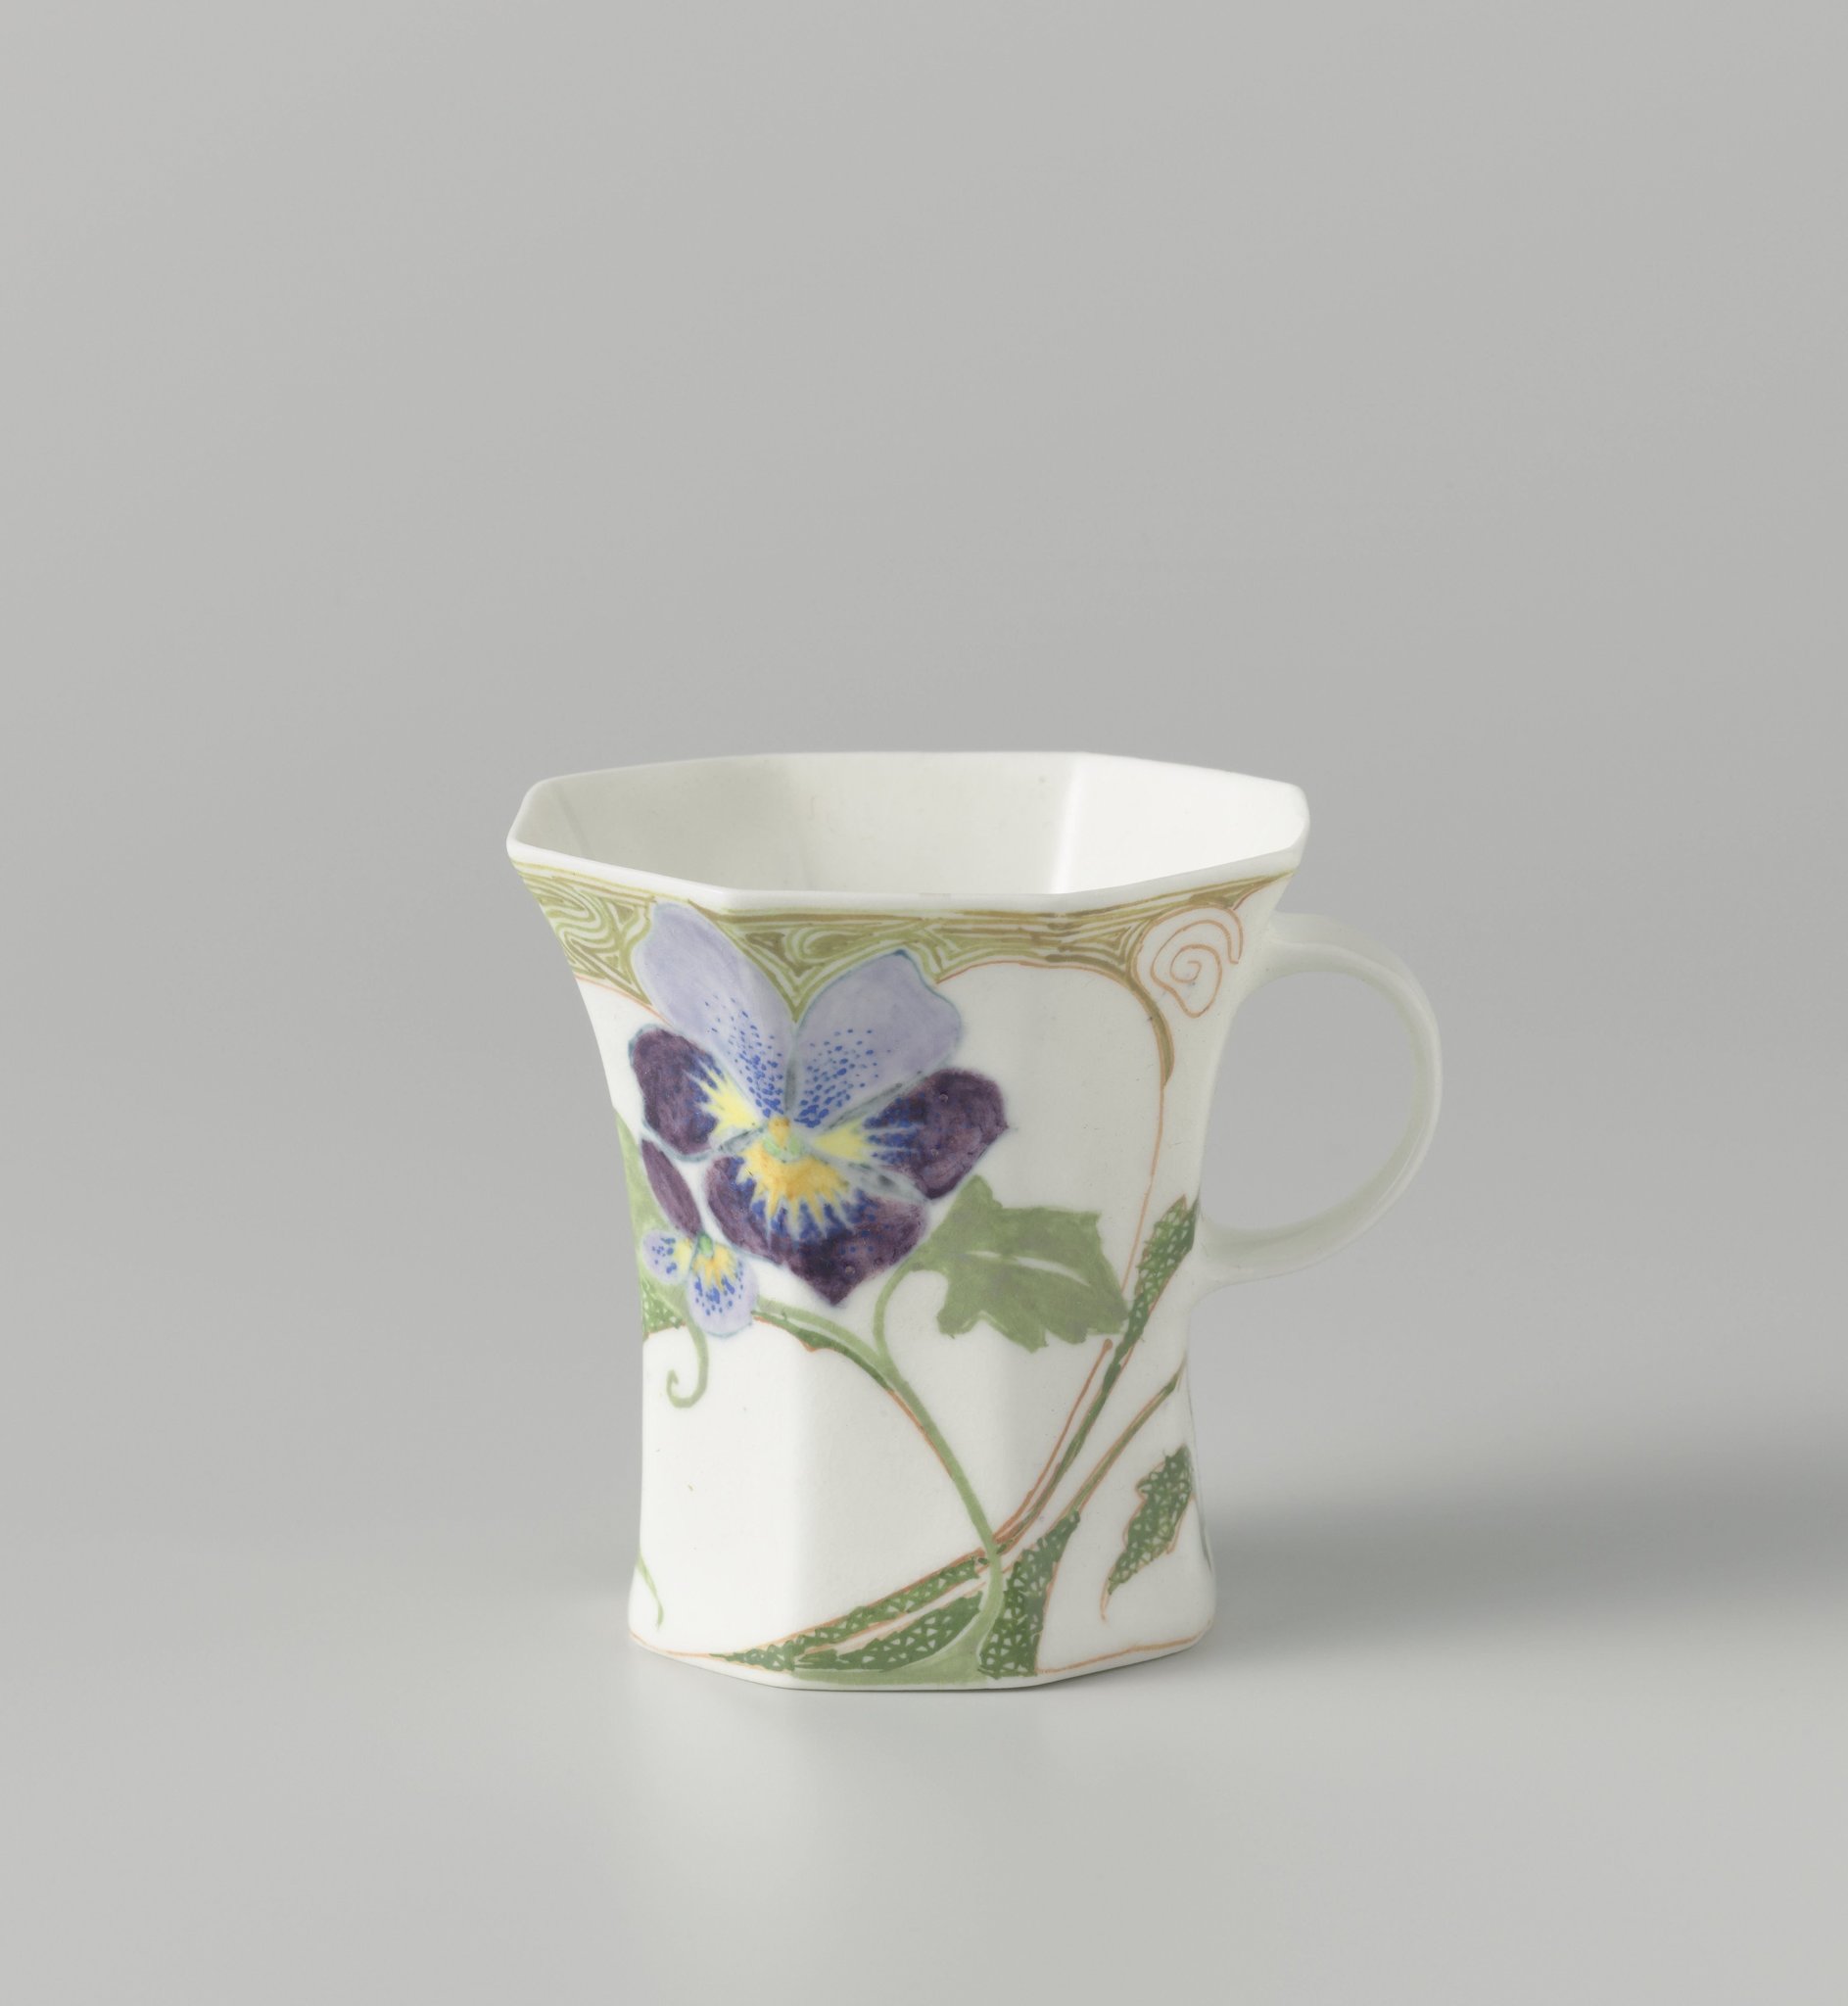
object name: cup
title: Kop, deel van een servies, beschilderd met violen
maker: c.w.j. t hart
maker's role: plateelschilder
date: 1913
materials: porcelain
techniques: painted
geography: the hague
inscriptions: mark: ‘kroon, Rozenburg, ooievaar, den Haag (boven elkaar); links het merk voor 1913, rechts het werkordernummer 332 (op een kop 333); onder het schildersmerk van C.W.J. 't Hart.’